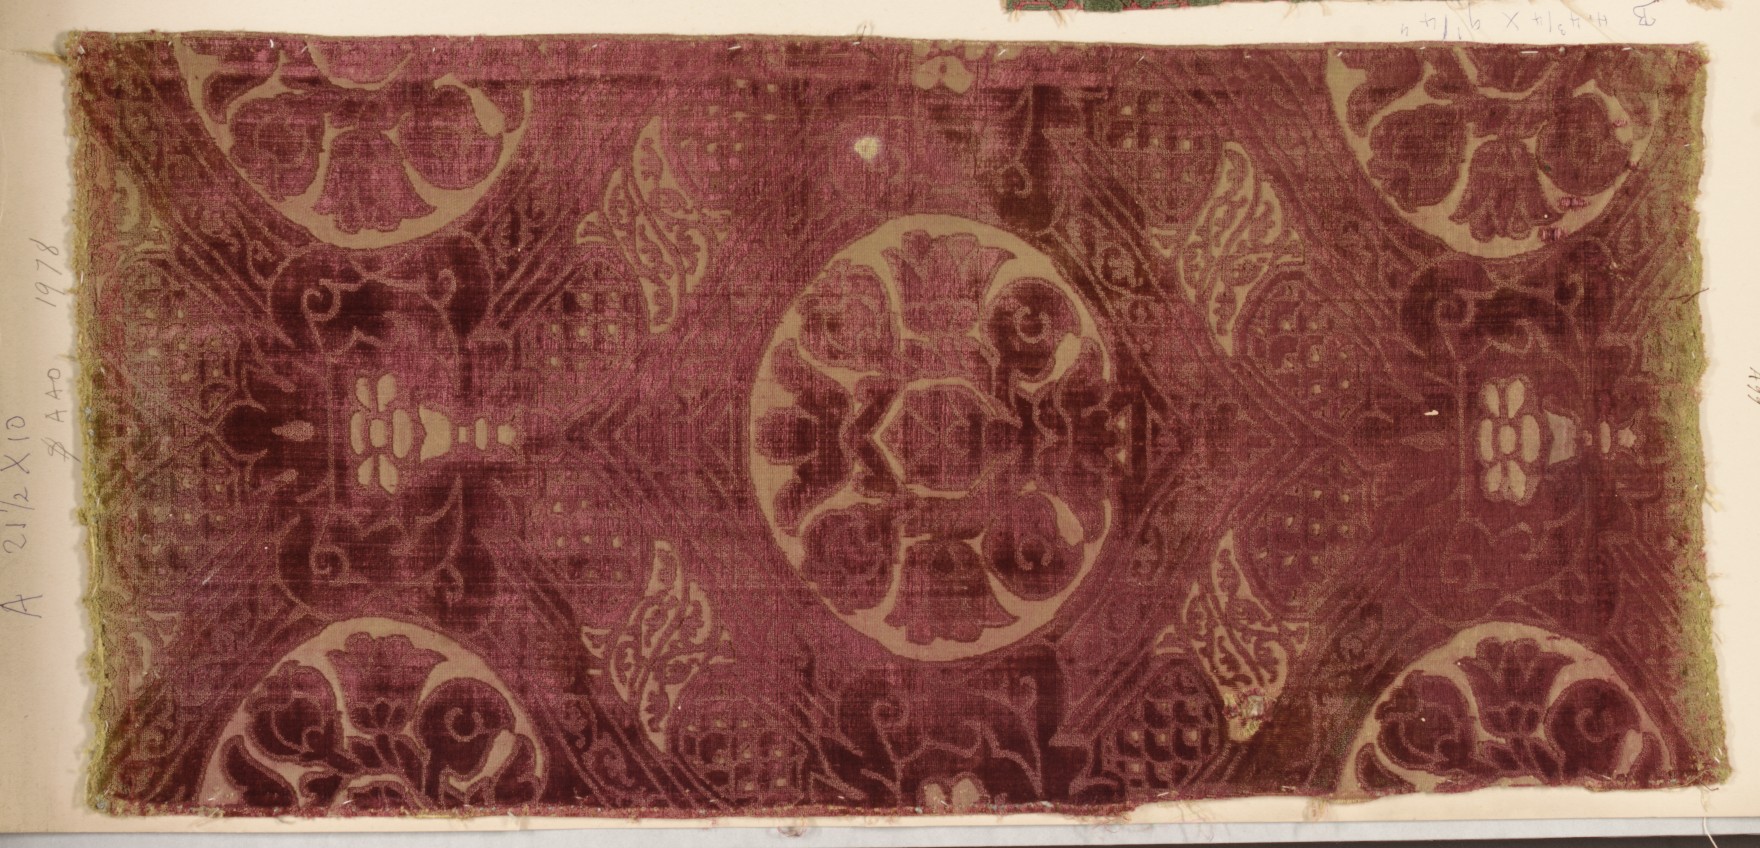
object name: fragment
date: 1567-1600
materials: silk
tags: flowers